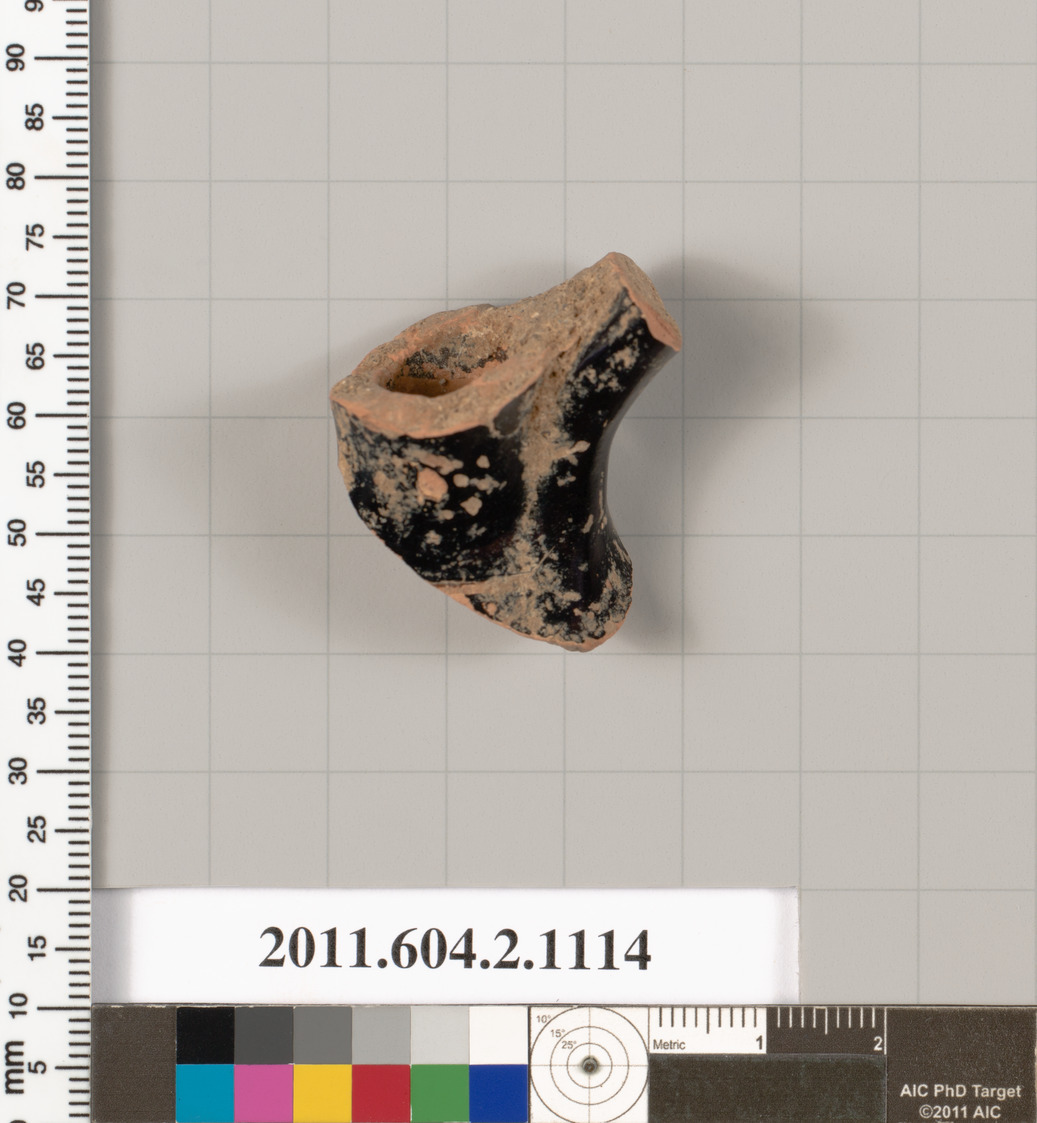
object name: lekythos fragment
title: Terracotta fragment of a lekythos (oil flask)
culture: greek, attic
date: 475-451 BCE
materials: terracotta